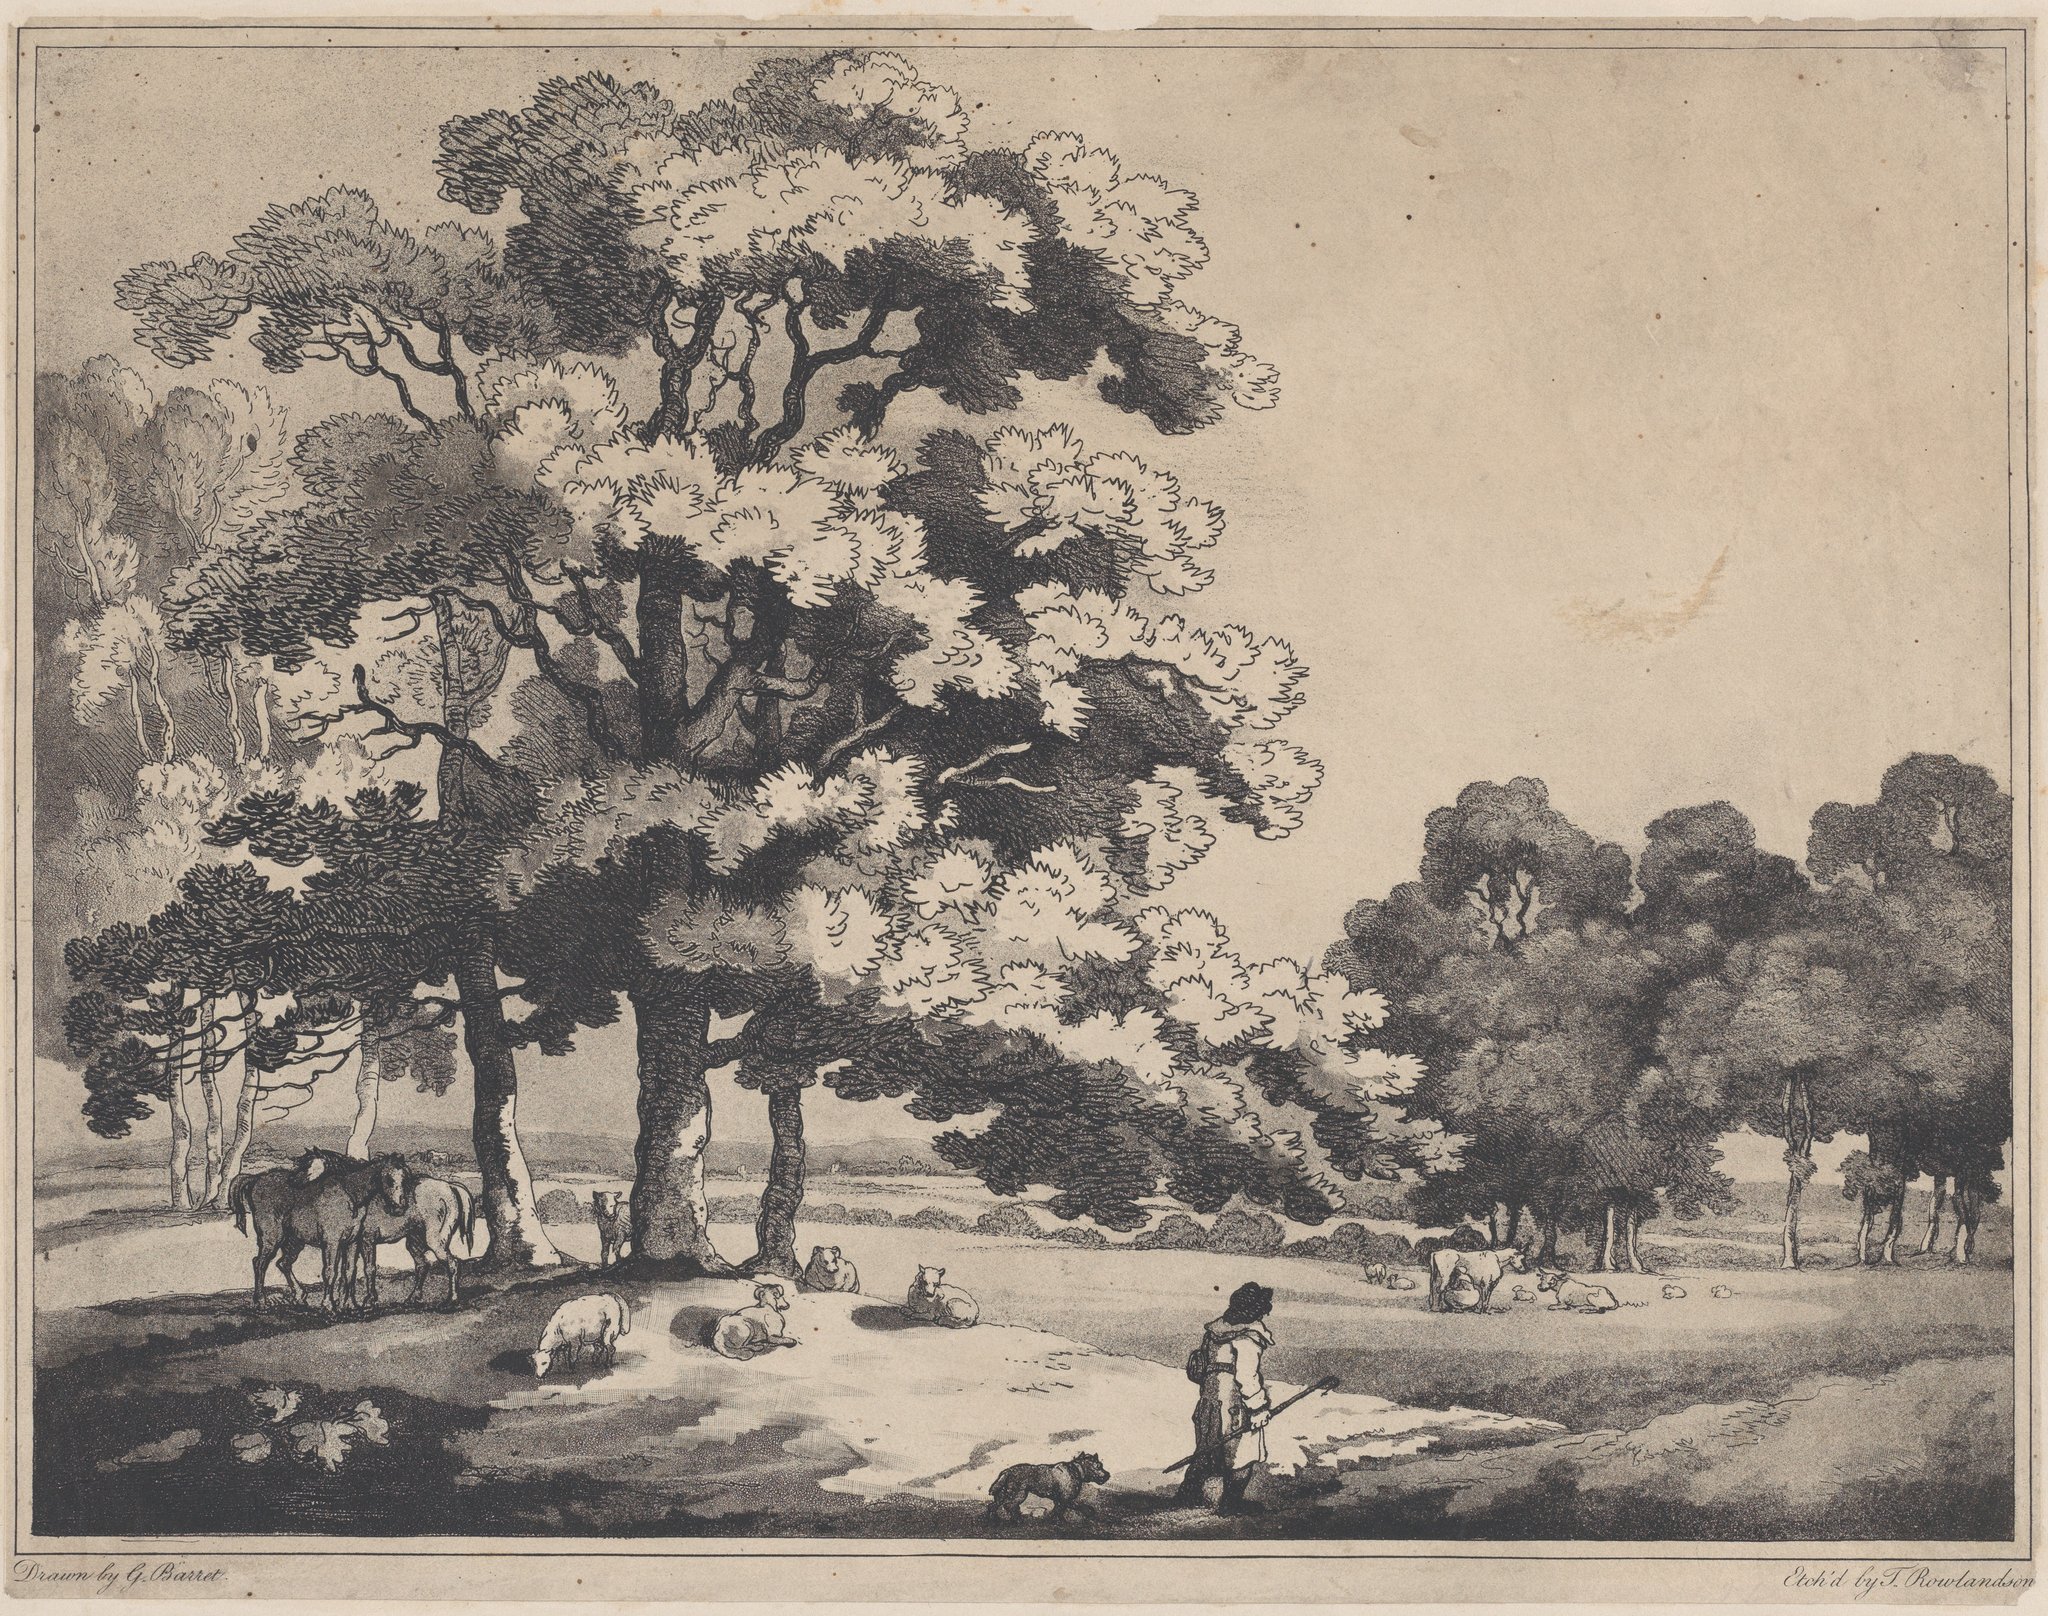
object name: print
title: A Park Landscape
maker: thomas rowlandson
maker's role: artist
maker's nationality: british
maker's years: 1757-1827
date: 1783-1789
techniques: aquatint, etching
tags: horses,sheep,landscapes